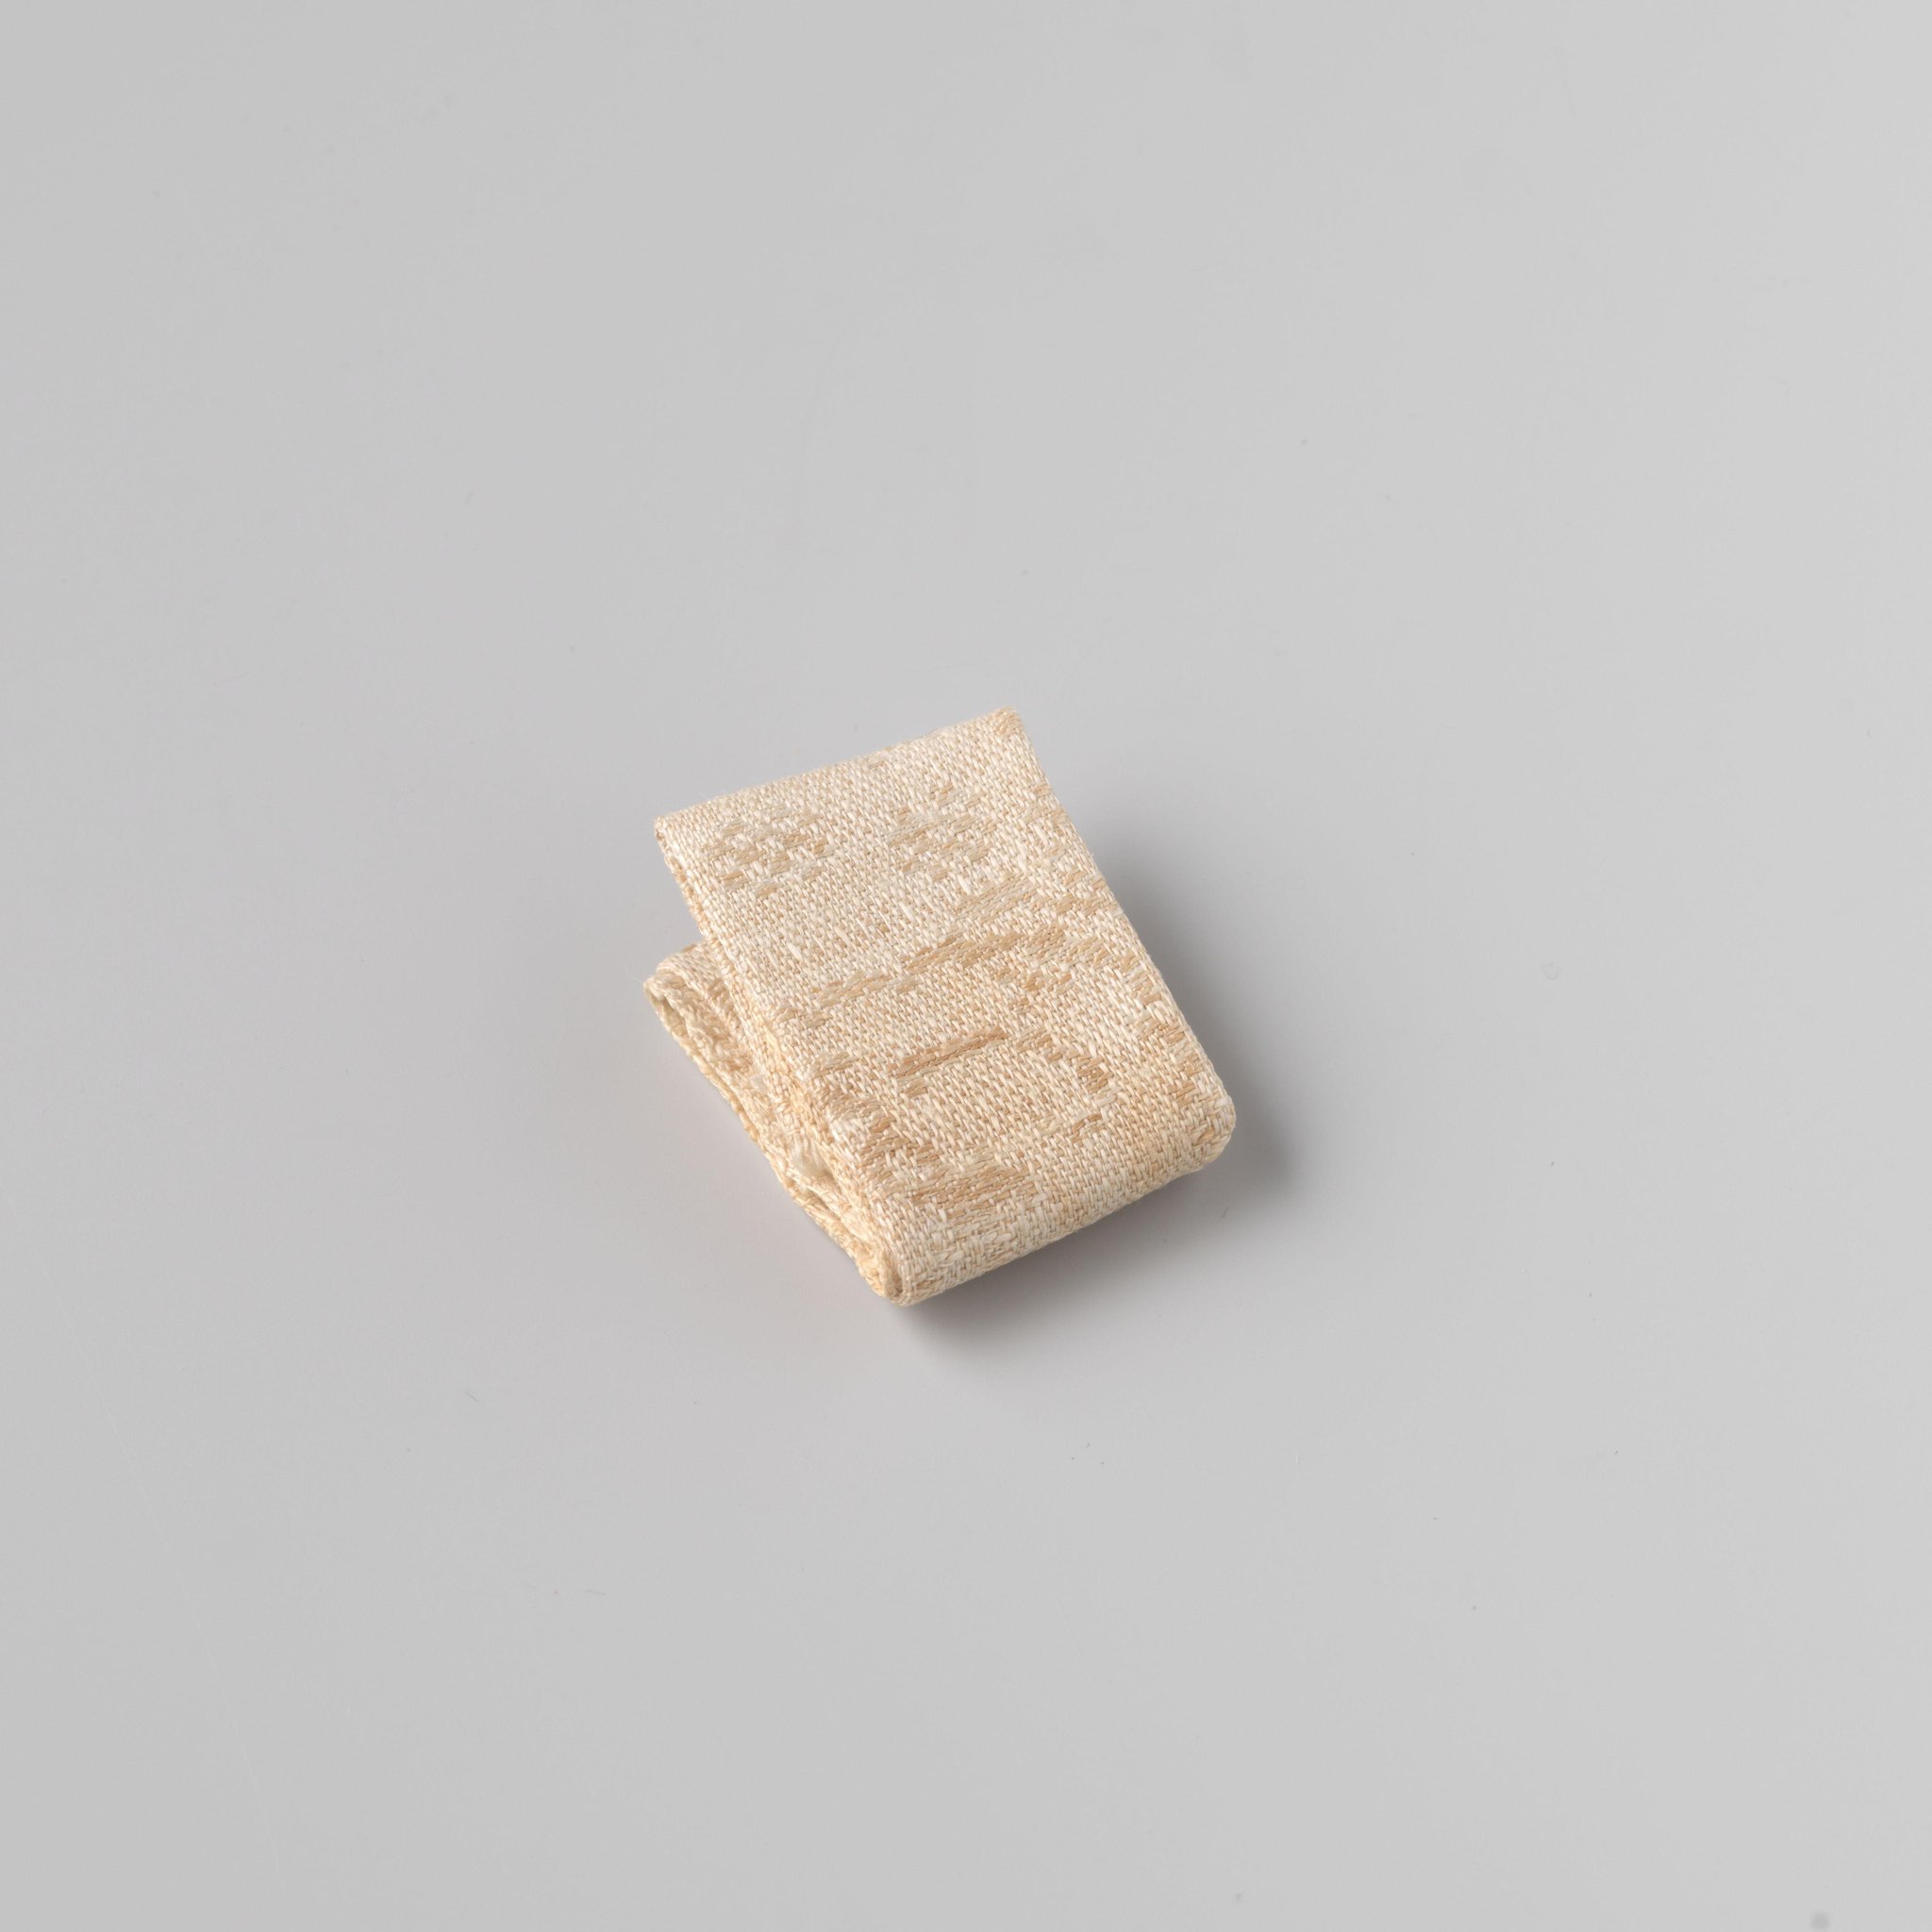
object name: dwaal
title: Linnen servet van damastweefsel, met centraal ingeweven monogram BO, waar boven en onder een vogel met opgeheven poot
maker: Anonymous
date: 1690-1710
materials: linen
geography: amsterdam